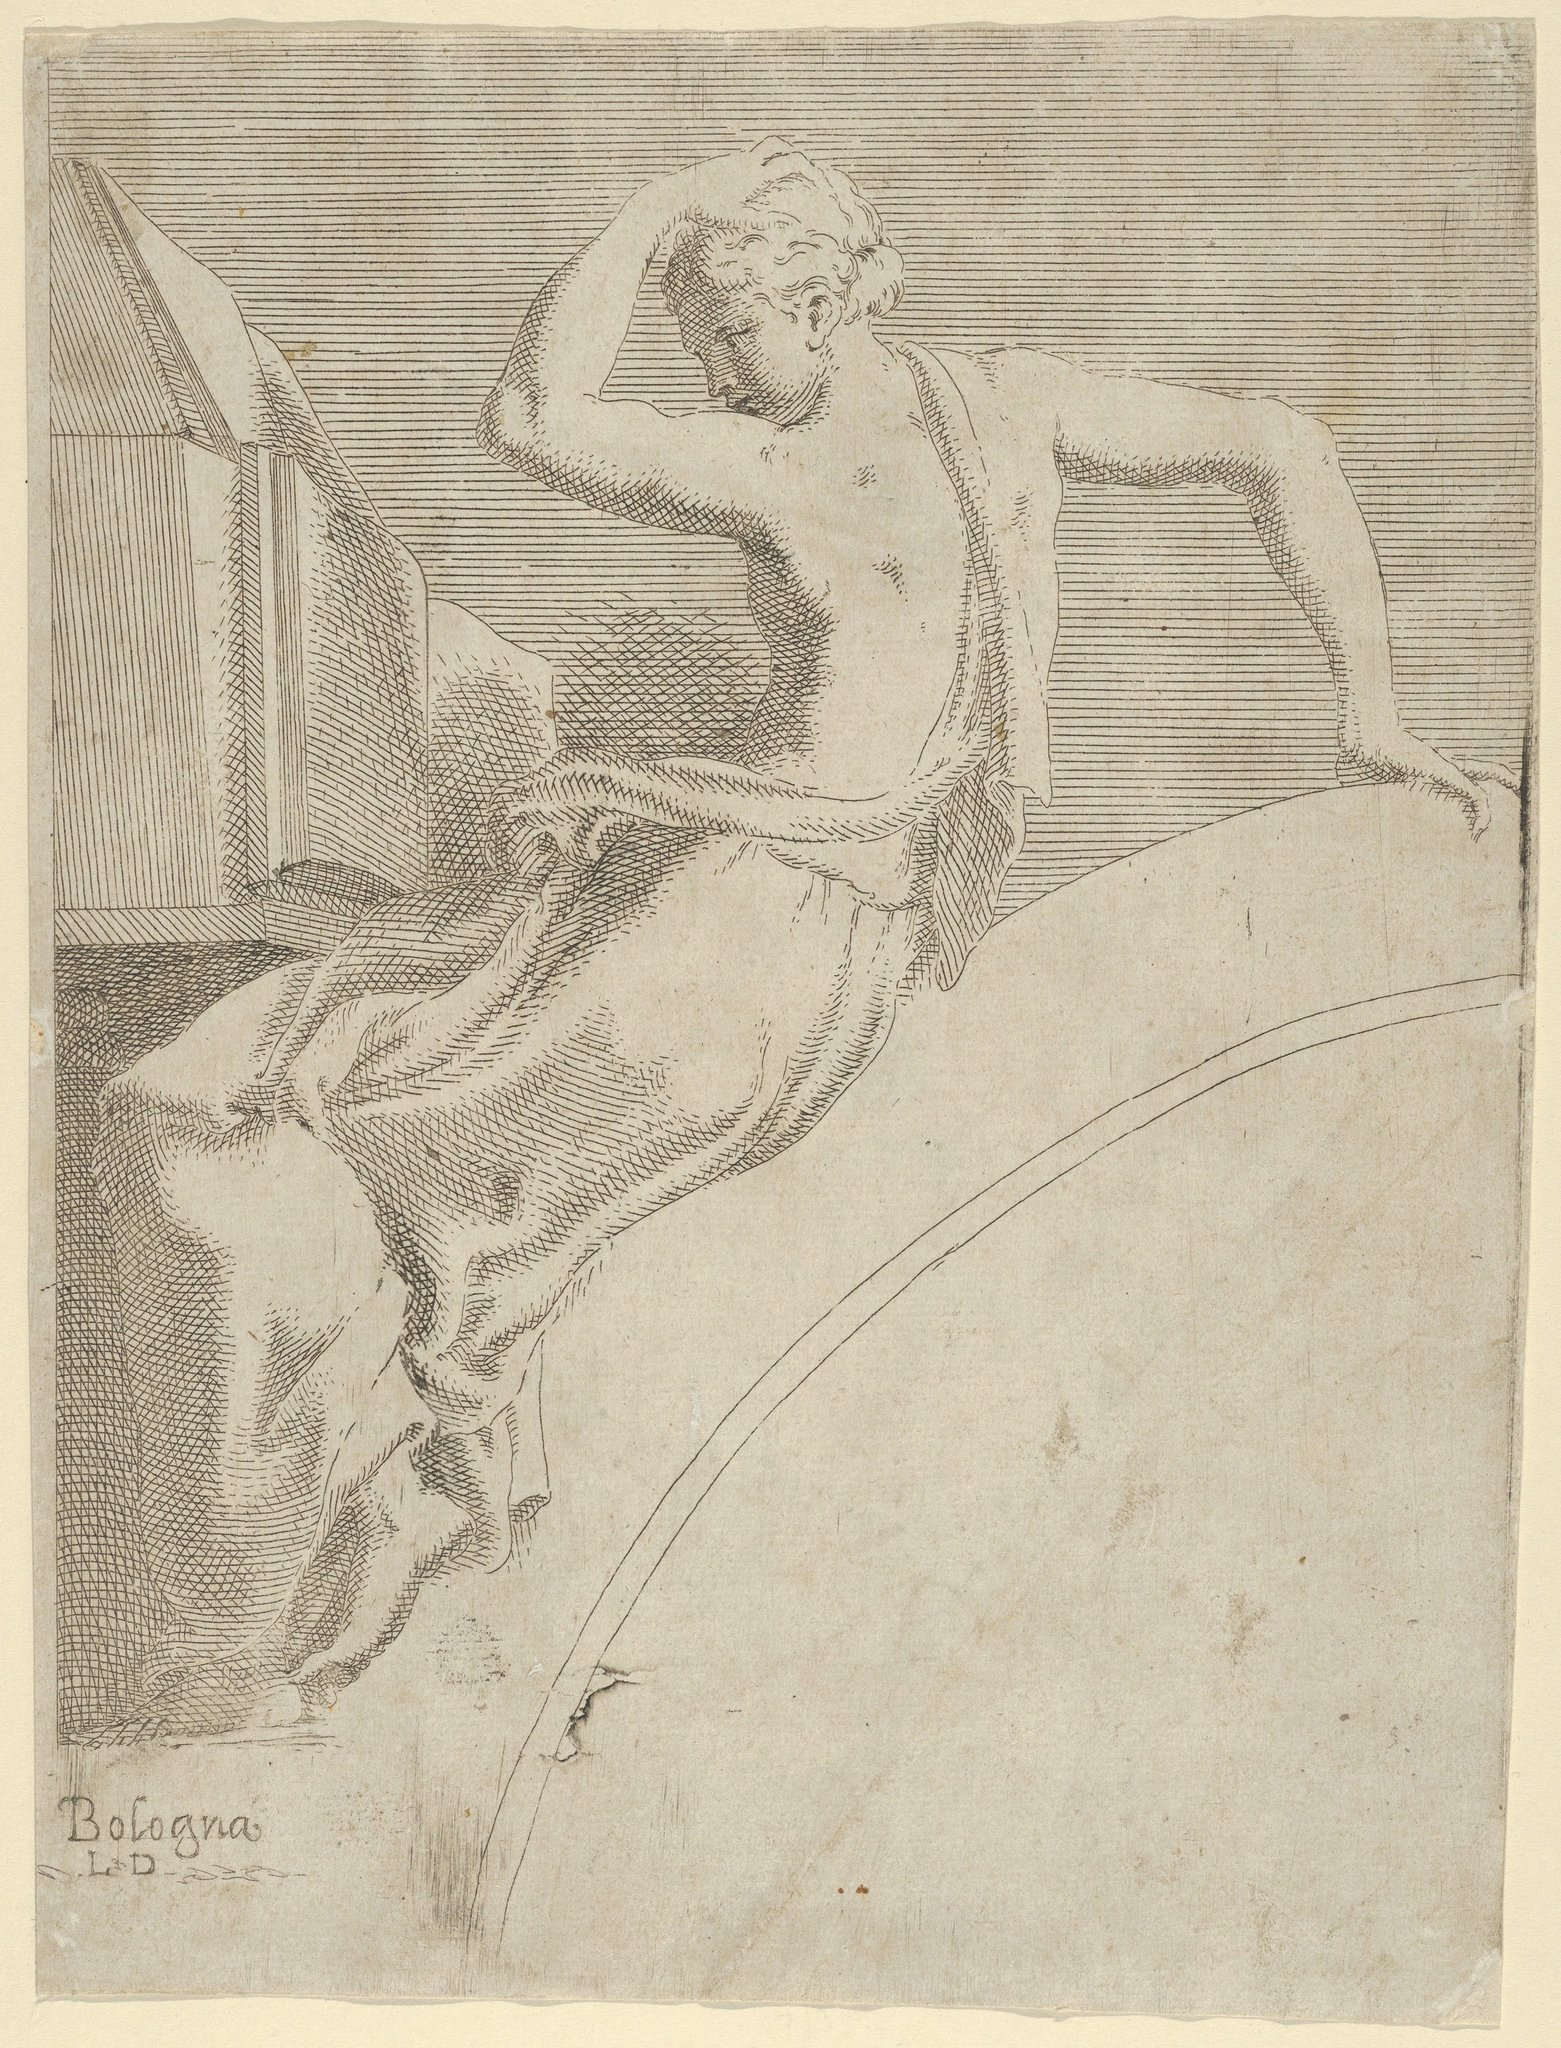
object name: print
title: Calliope, from "Twelve Muses and Goddesses"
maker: léon davent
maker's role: artist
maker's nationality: french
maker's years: 1540-1556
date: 1542-1545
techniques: etching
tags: women,muses